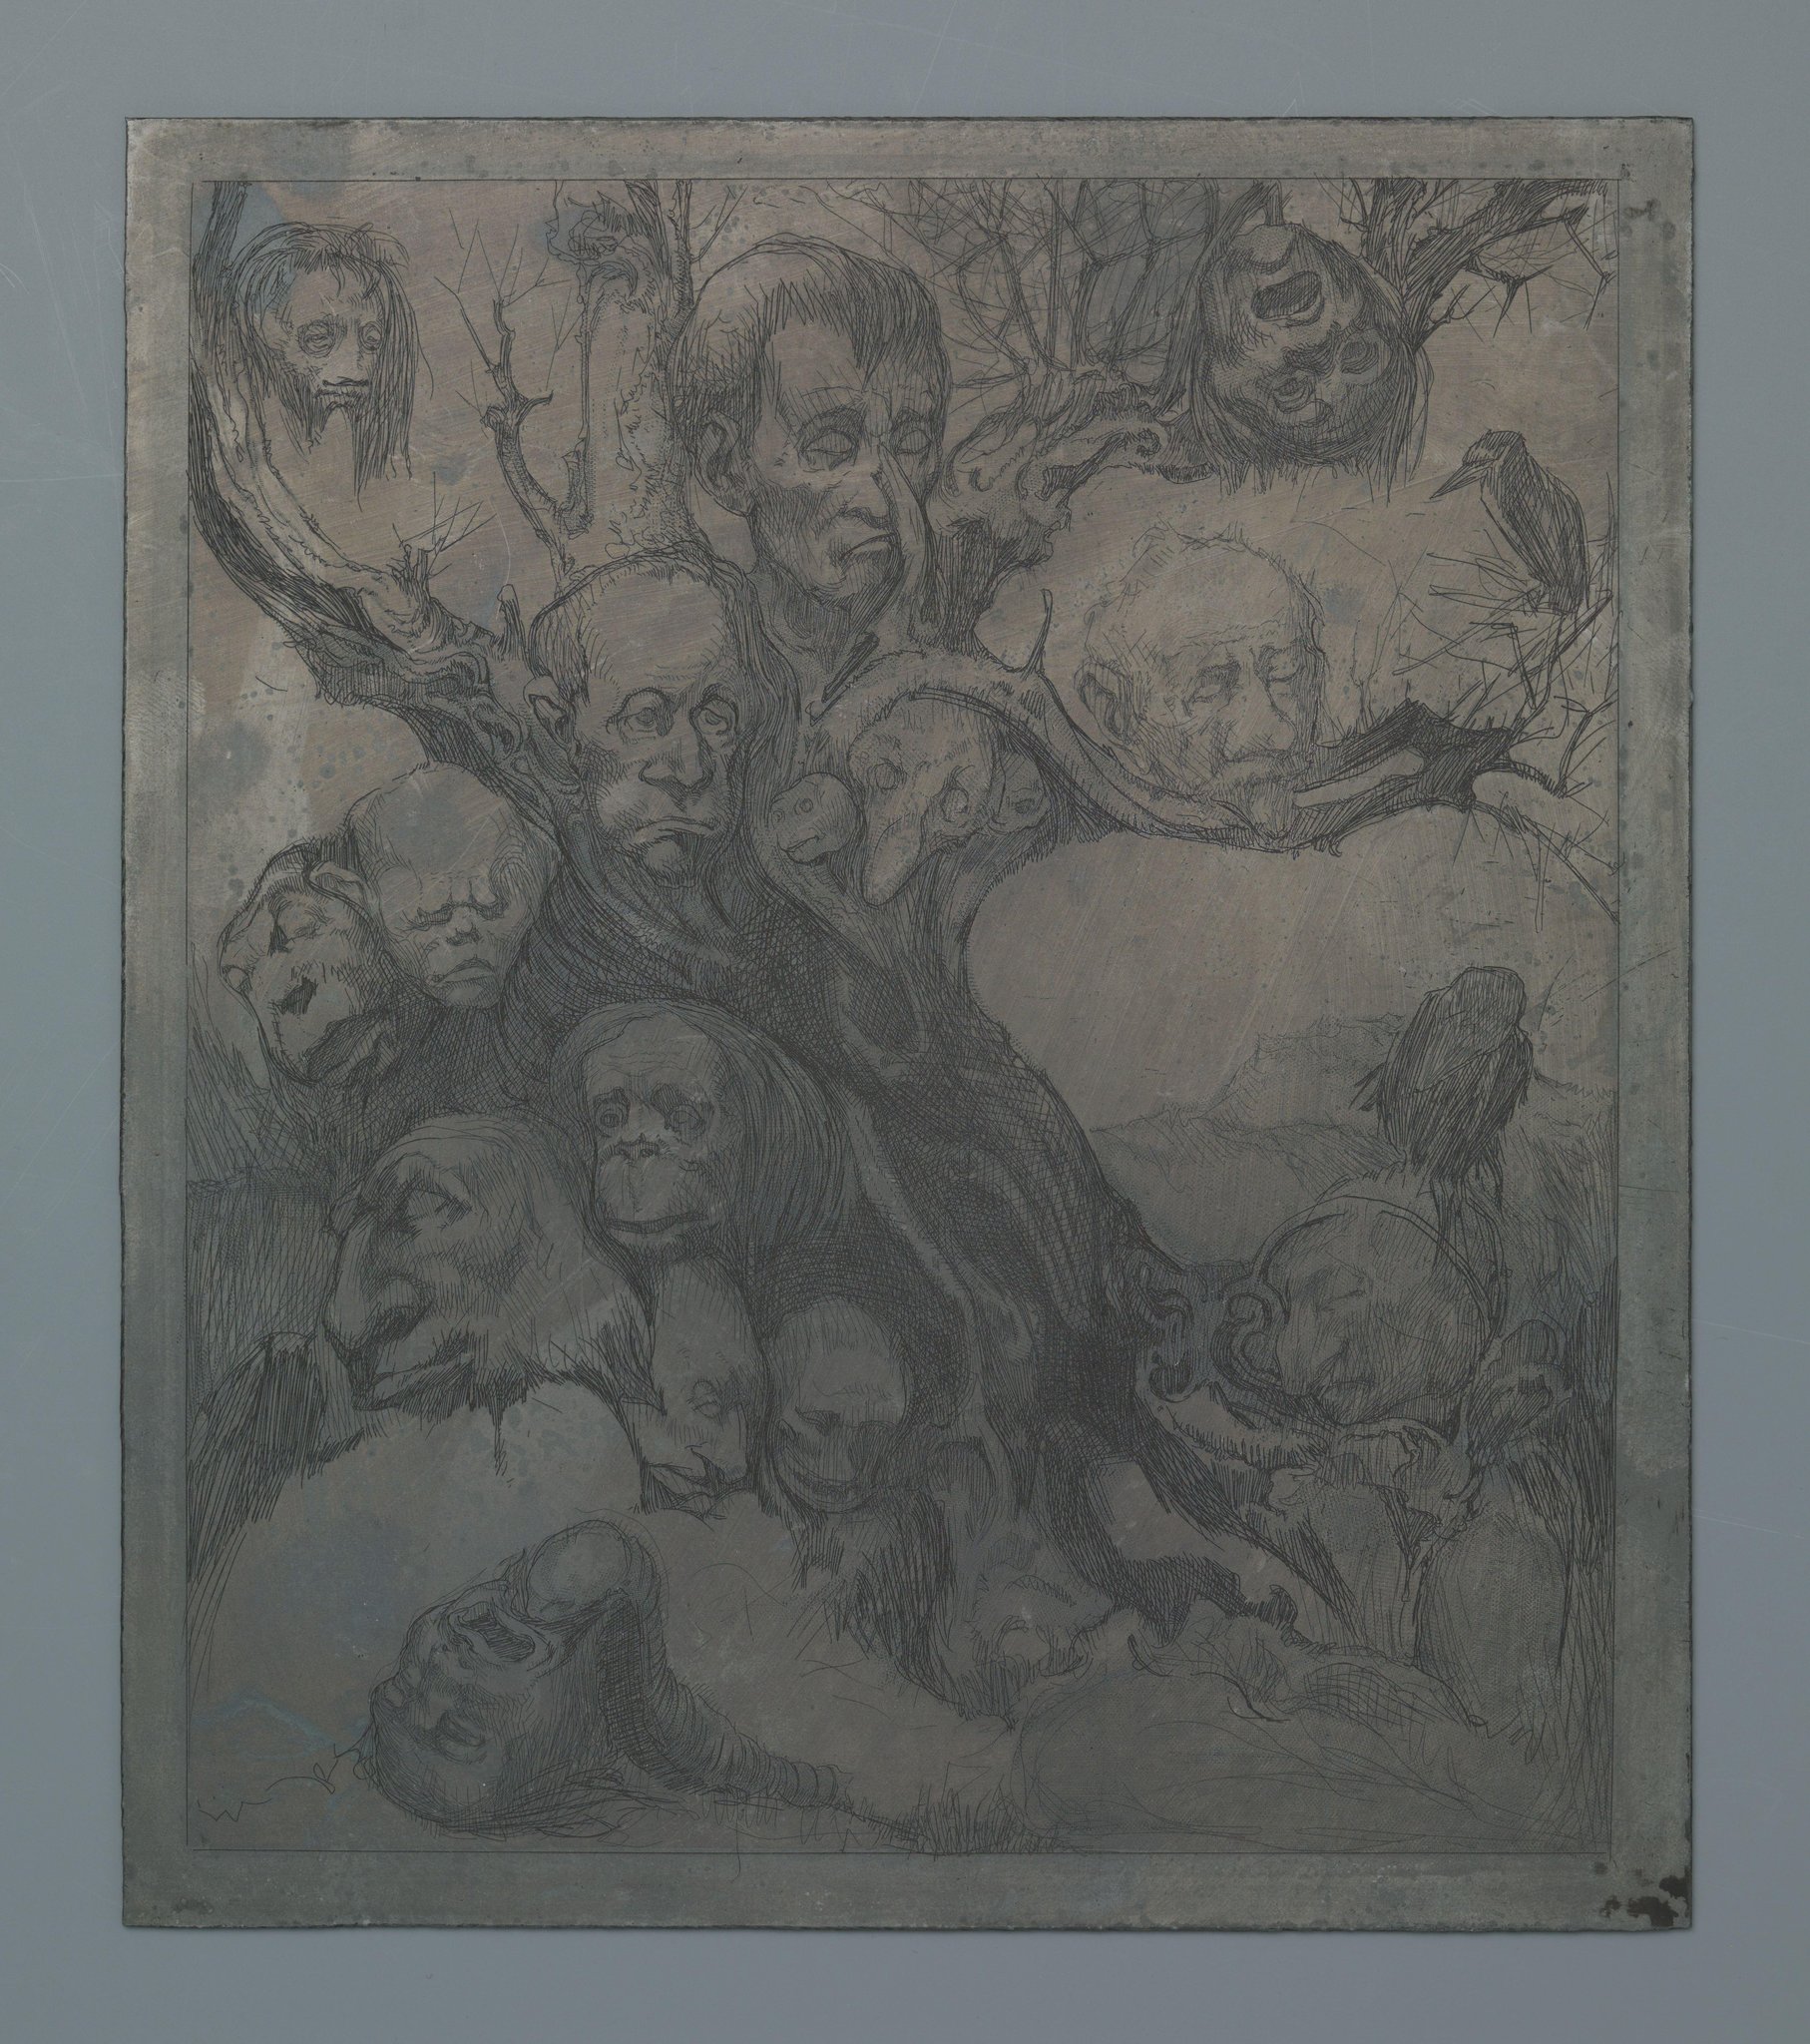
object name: zinkplaat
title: Boom met fantastiekoppen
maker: johannes josephus aarts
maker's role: draughtsman, print maker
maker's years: 1871-1934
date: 1881-1934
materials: zinc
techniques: etching, roulette